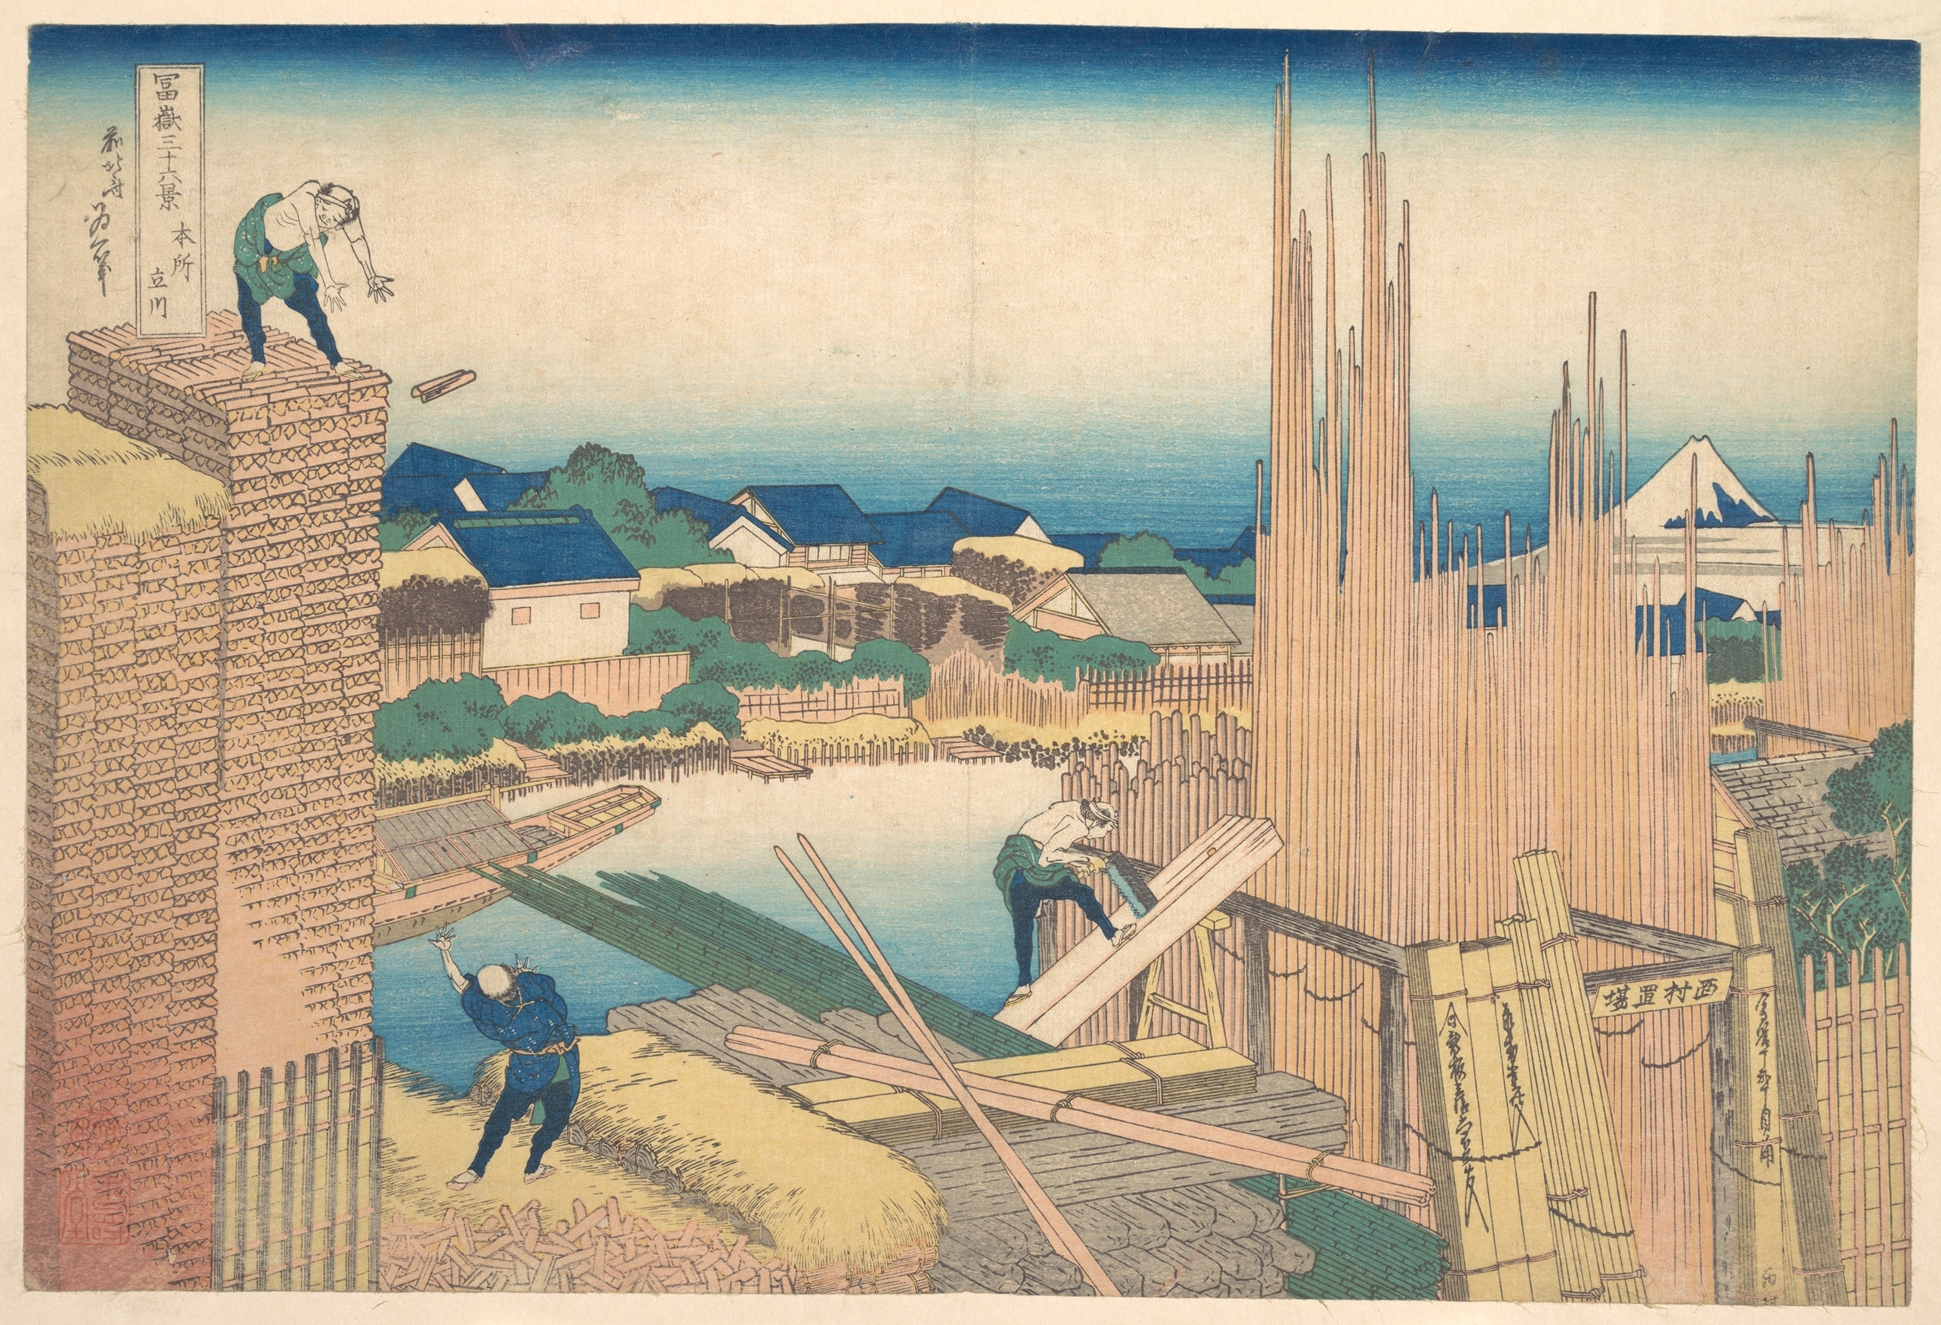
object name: woodblock print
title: Tatekawa in Honjō (Honjō Tatekawa), from the series Thirty-six Views of Mount Fuji (Fugaku sanjūrokkei)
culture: japanese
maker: katsushika hokusai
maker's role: artist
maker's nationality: japanese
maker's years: 1760-1849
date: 1830-1832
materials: ink, paper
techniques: woodblock print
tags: buildings,men,working